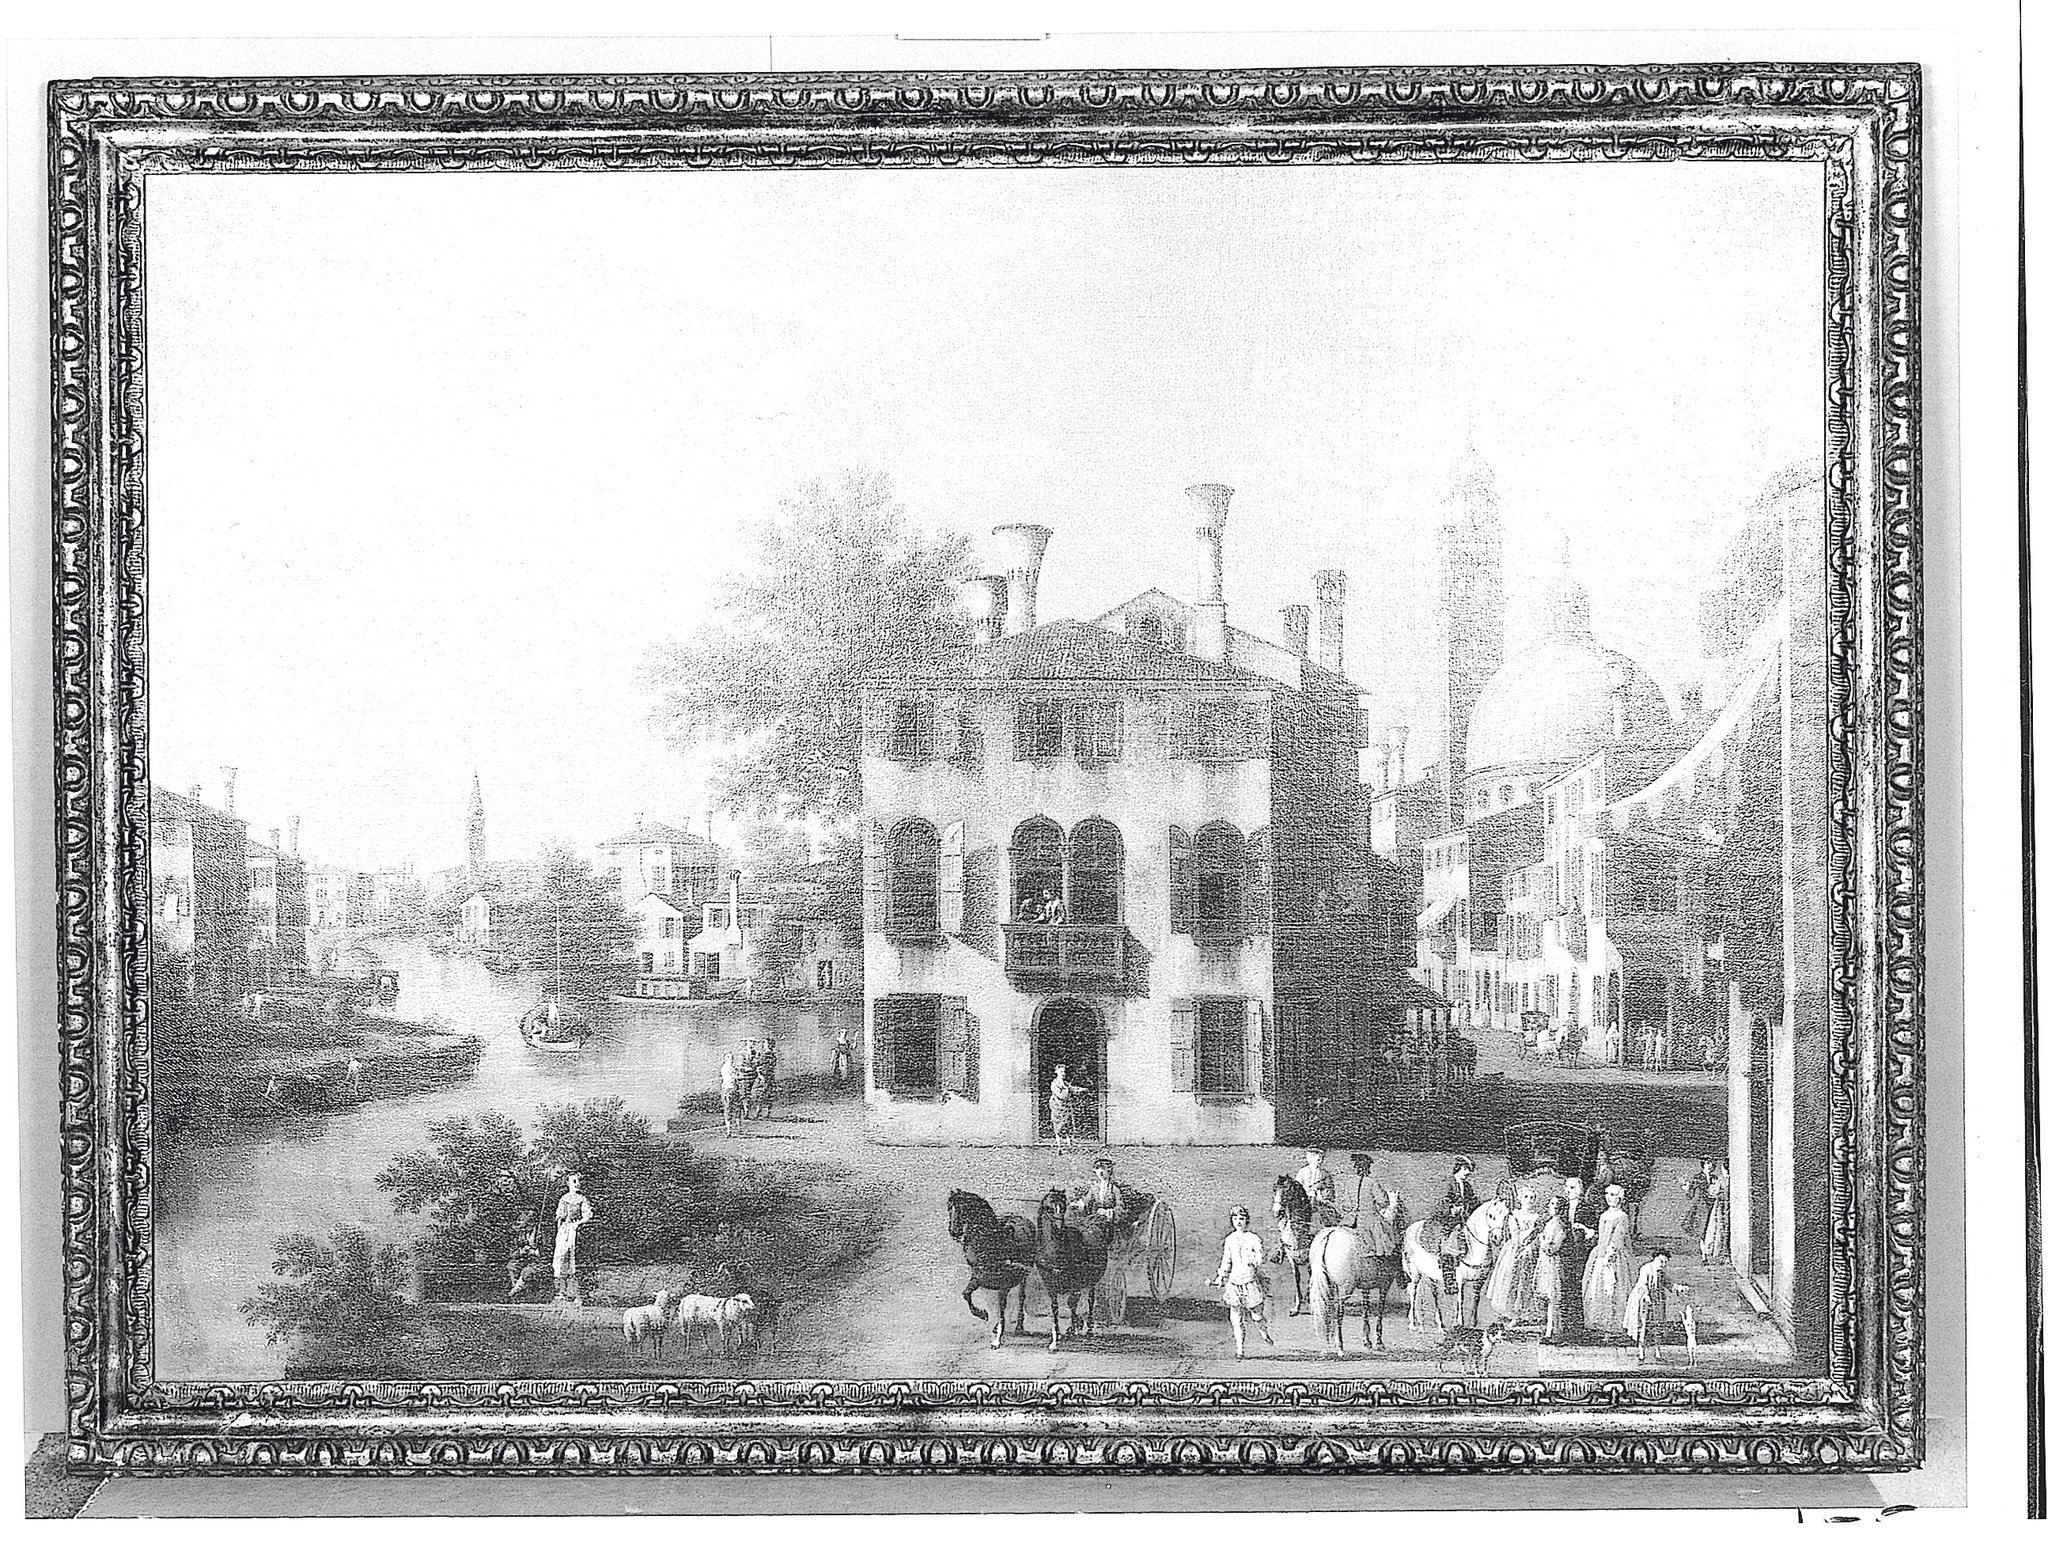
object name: frame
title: Salvator Rosa frame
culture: italian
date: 1667-1700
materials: wood